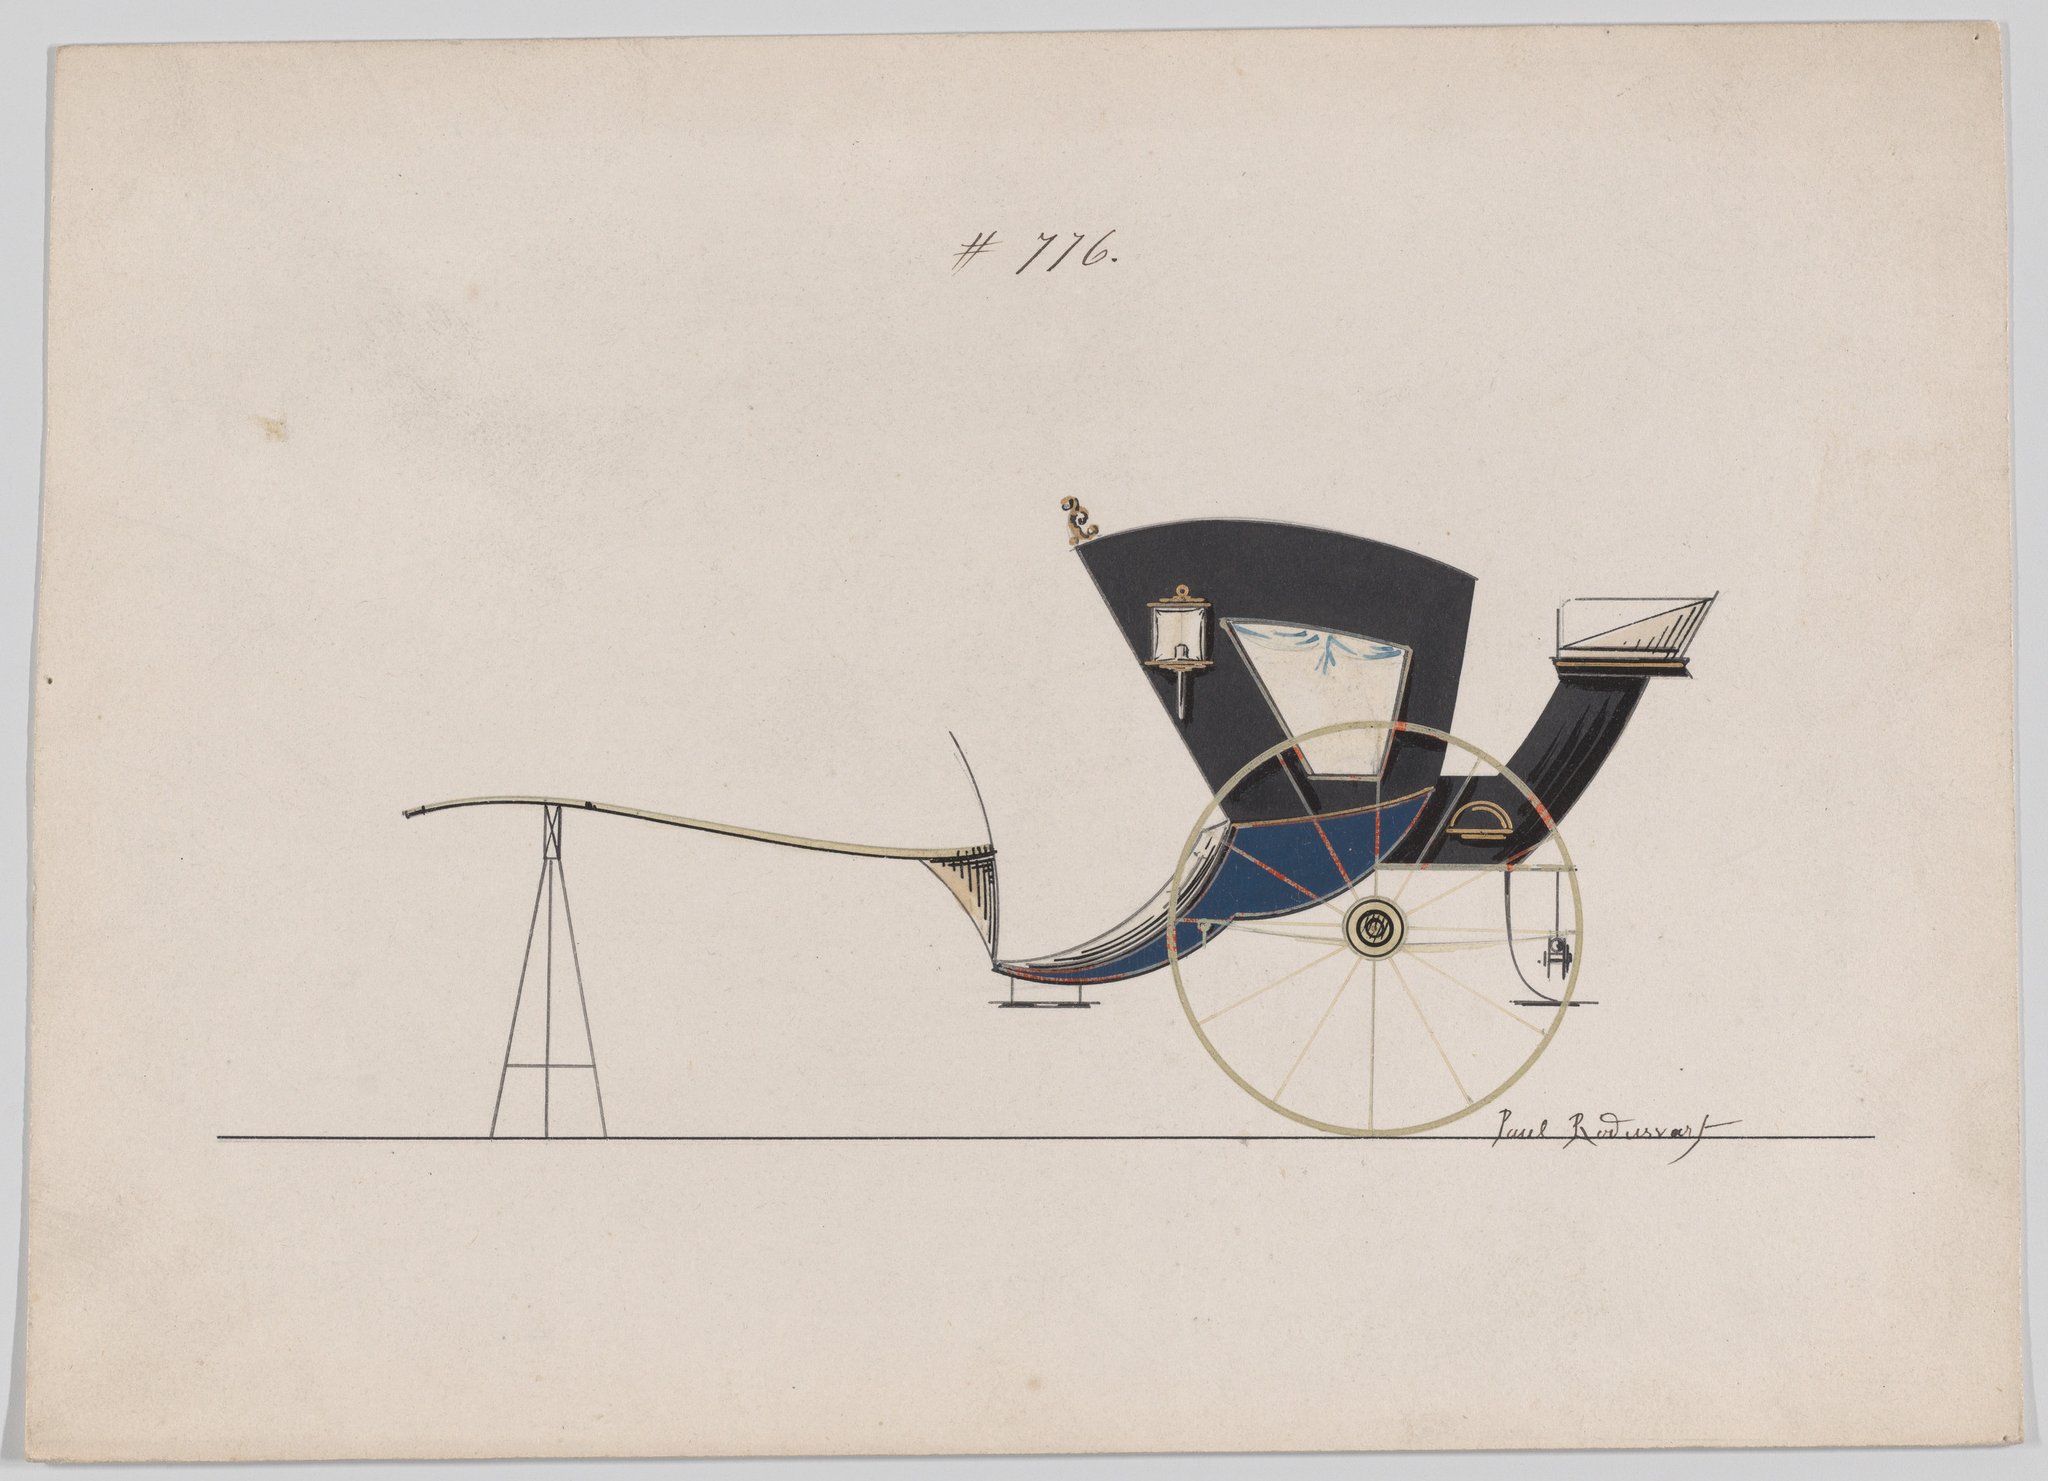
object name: drawing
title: Hansom Cab # 776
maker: brewster & co.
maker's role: manufacturer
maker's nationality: american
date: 1860-1870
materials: gouache, ink, watercolor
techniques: pen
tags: carriages